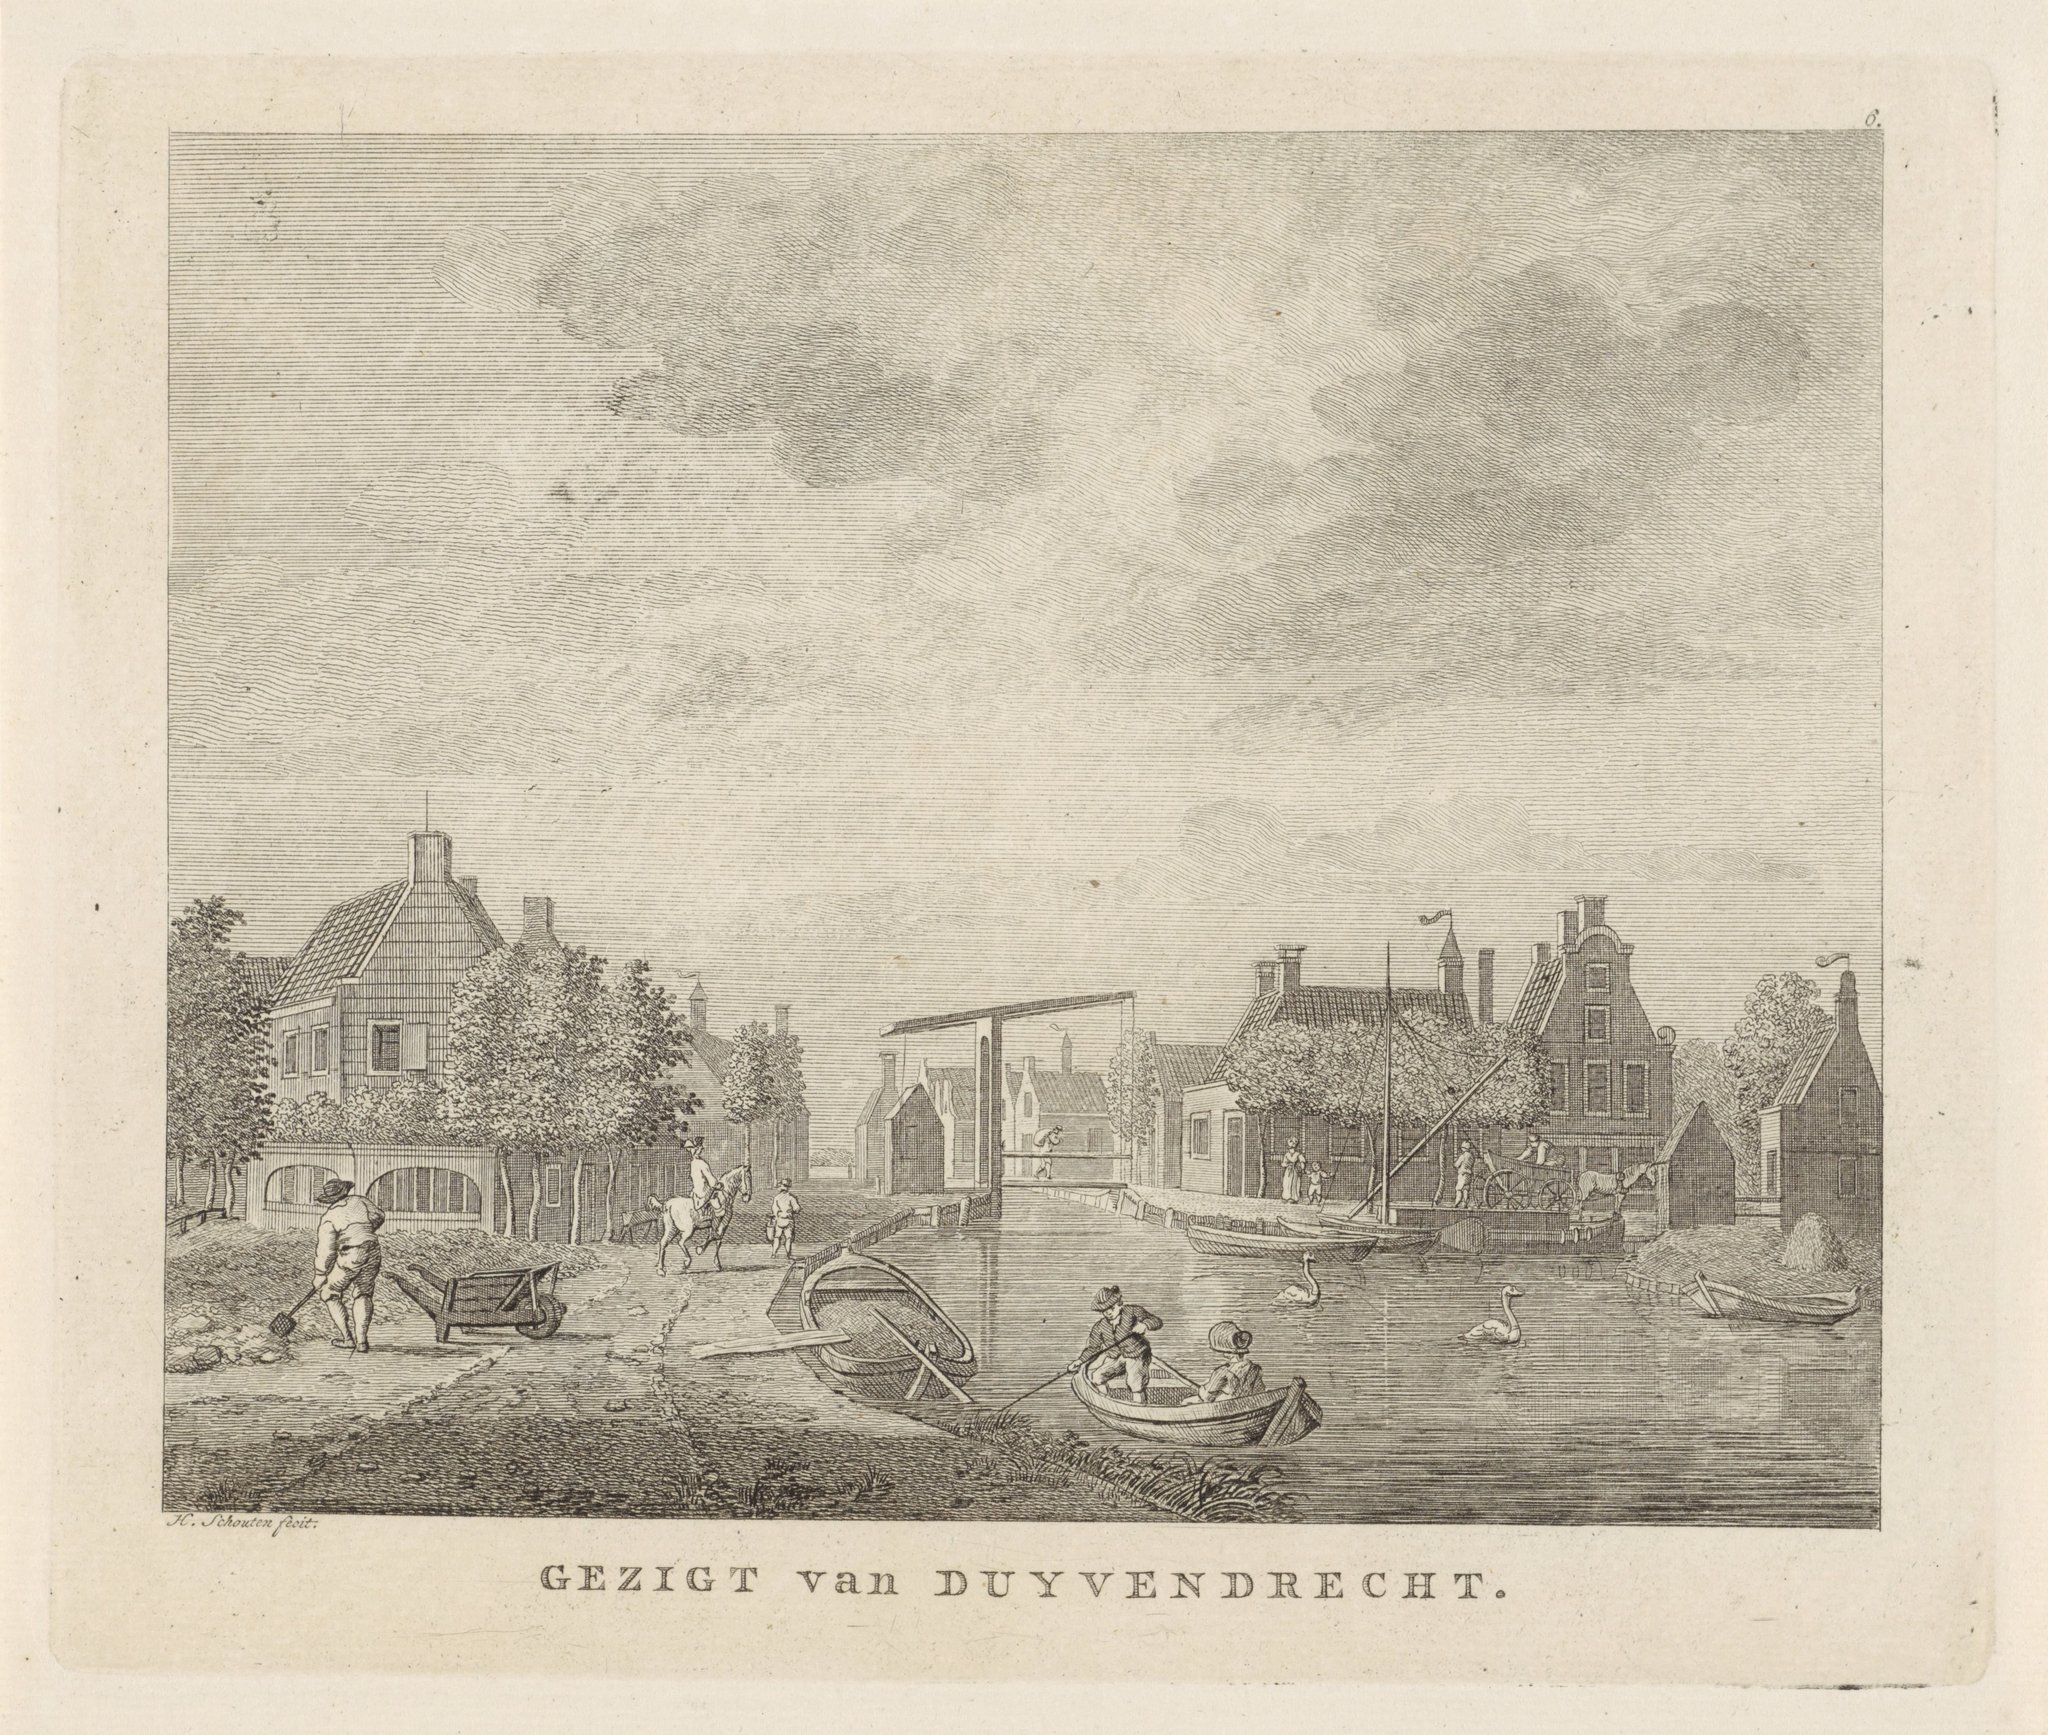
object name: print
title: Gezigt van Duyvendrecht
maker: hermanus petrus schouten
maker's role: draughtsman, painter, print maker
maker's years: 1747-1822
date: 1762-1822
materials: paper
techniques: etching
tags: duivendrecht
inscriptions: collector's mark: Lugt 2228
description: Gezicht op de Duivendrechtse brug. Links Duivendrecht, rechts de Watergraafsmeer. Rechtsboven genummerd "6".